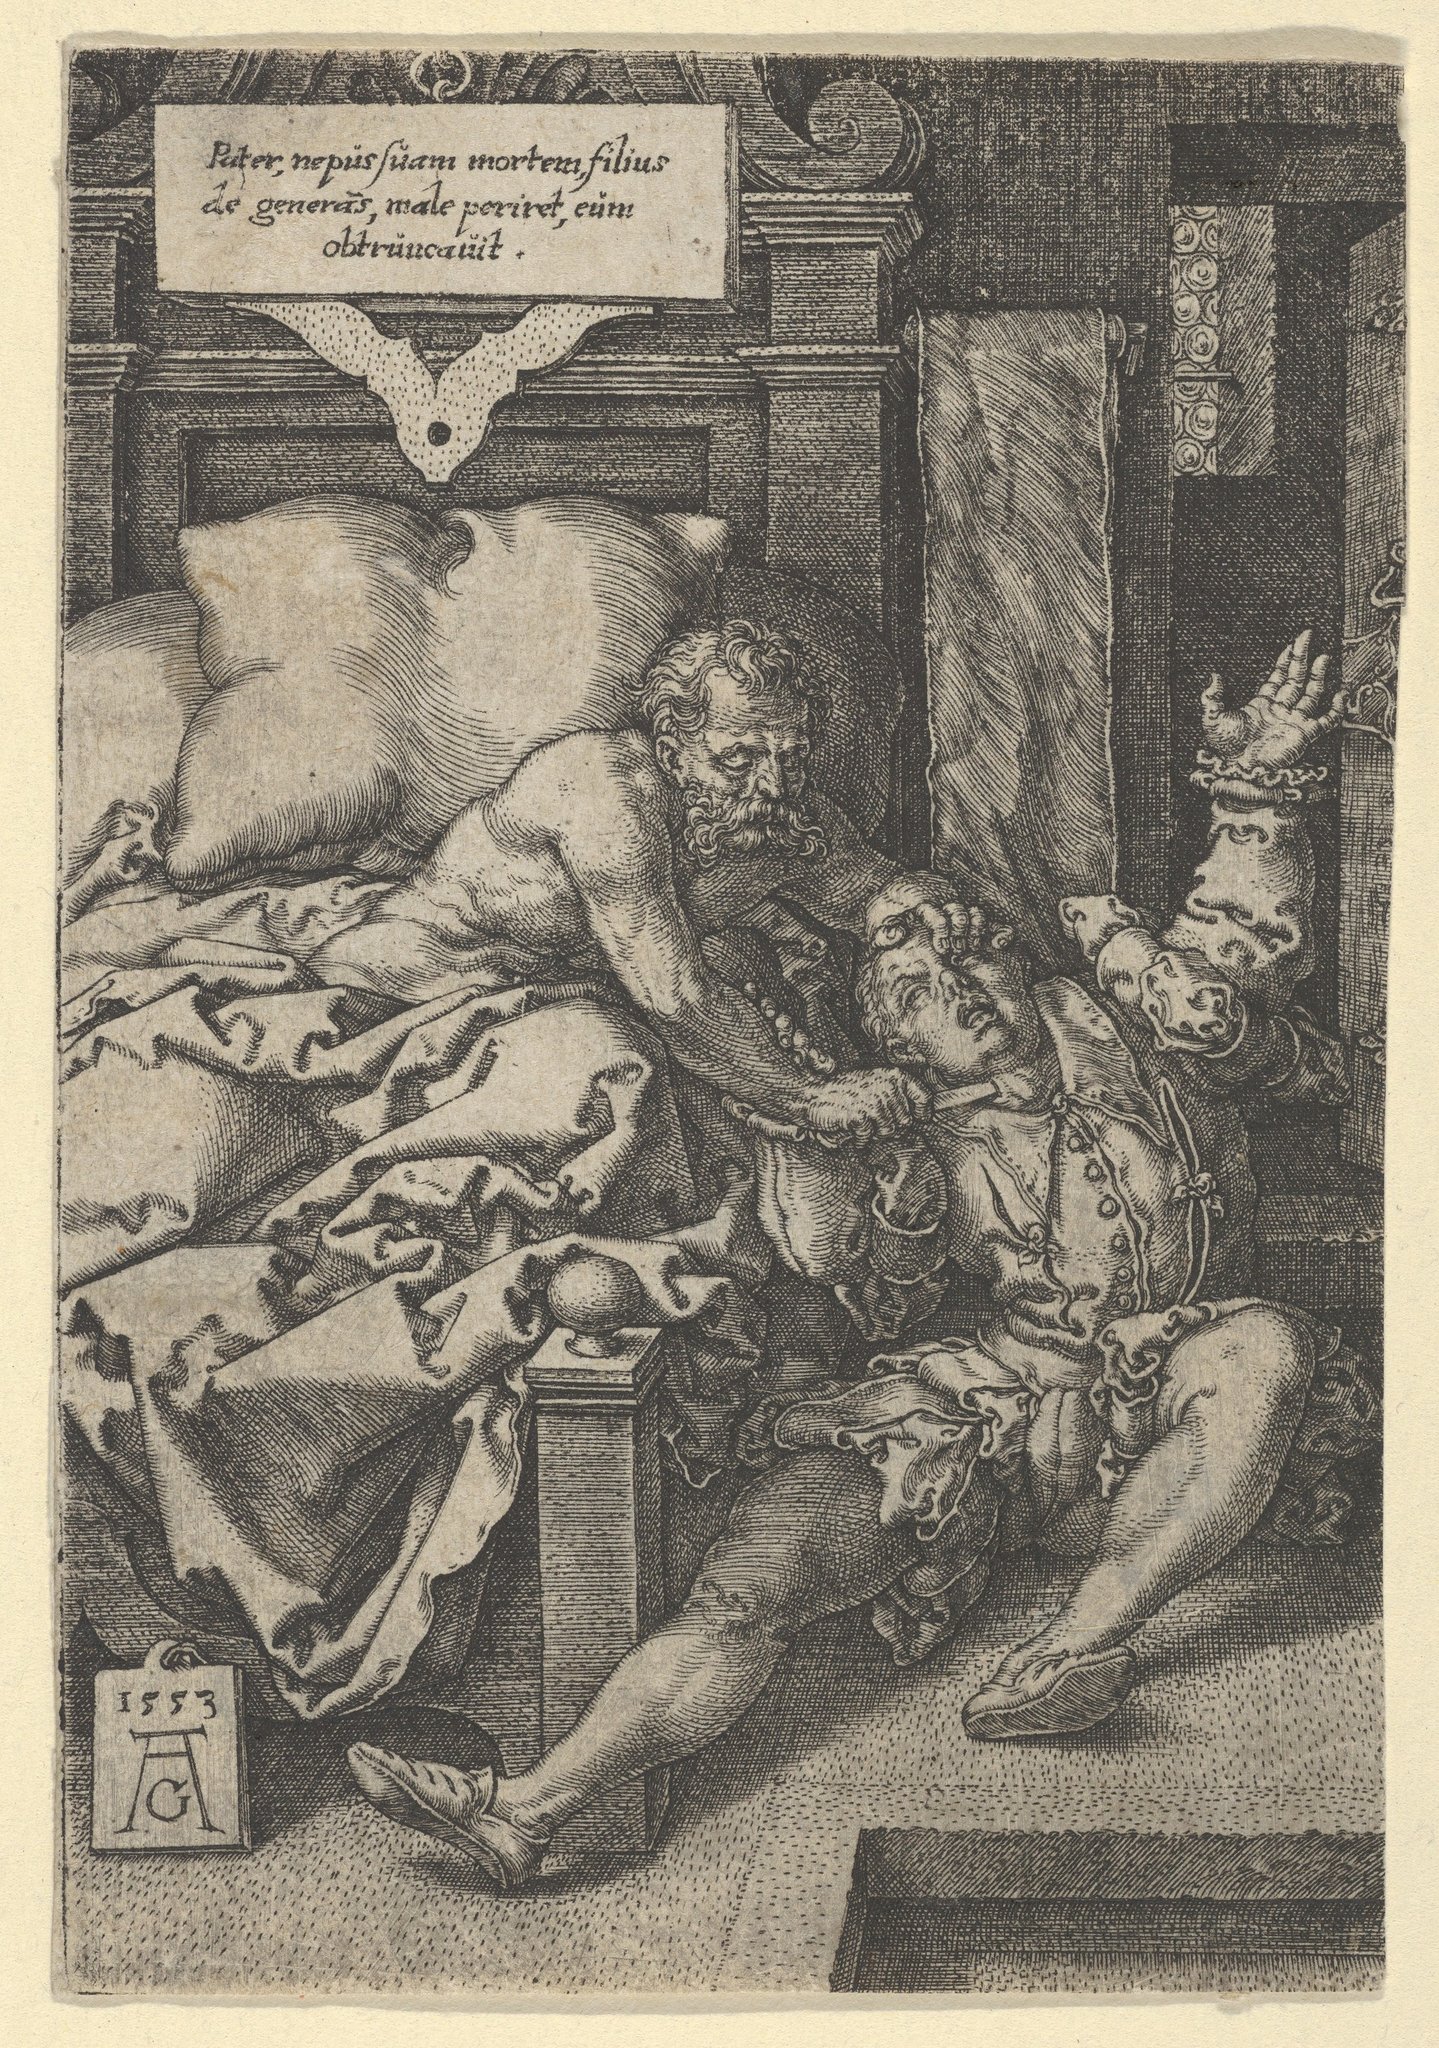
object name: print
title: Judge Herkinbald (Archambauld) Stabbing His Nephew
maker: heinrich aldegrever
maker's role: artist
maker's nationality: german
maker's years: 1502-1561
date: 1553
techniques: engraving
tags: bedrooms,suffering,men